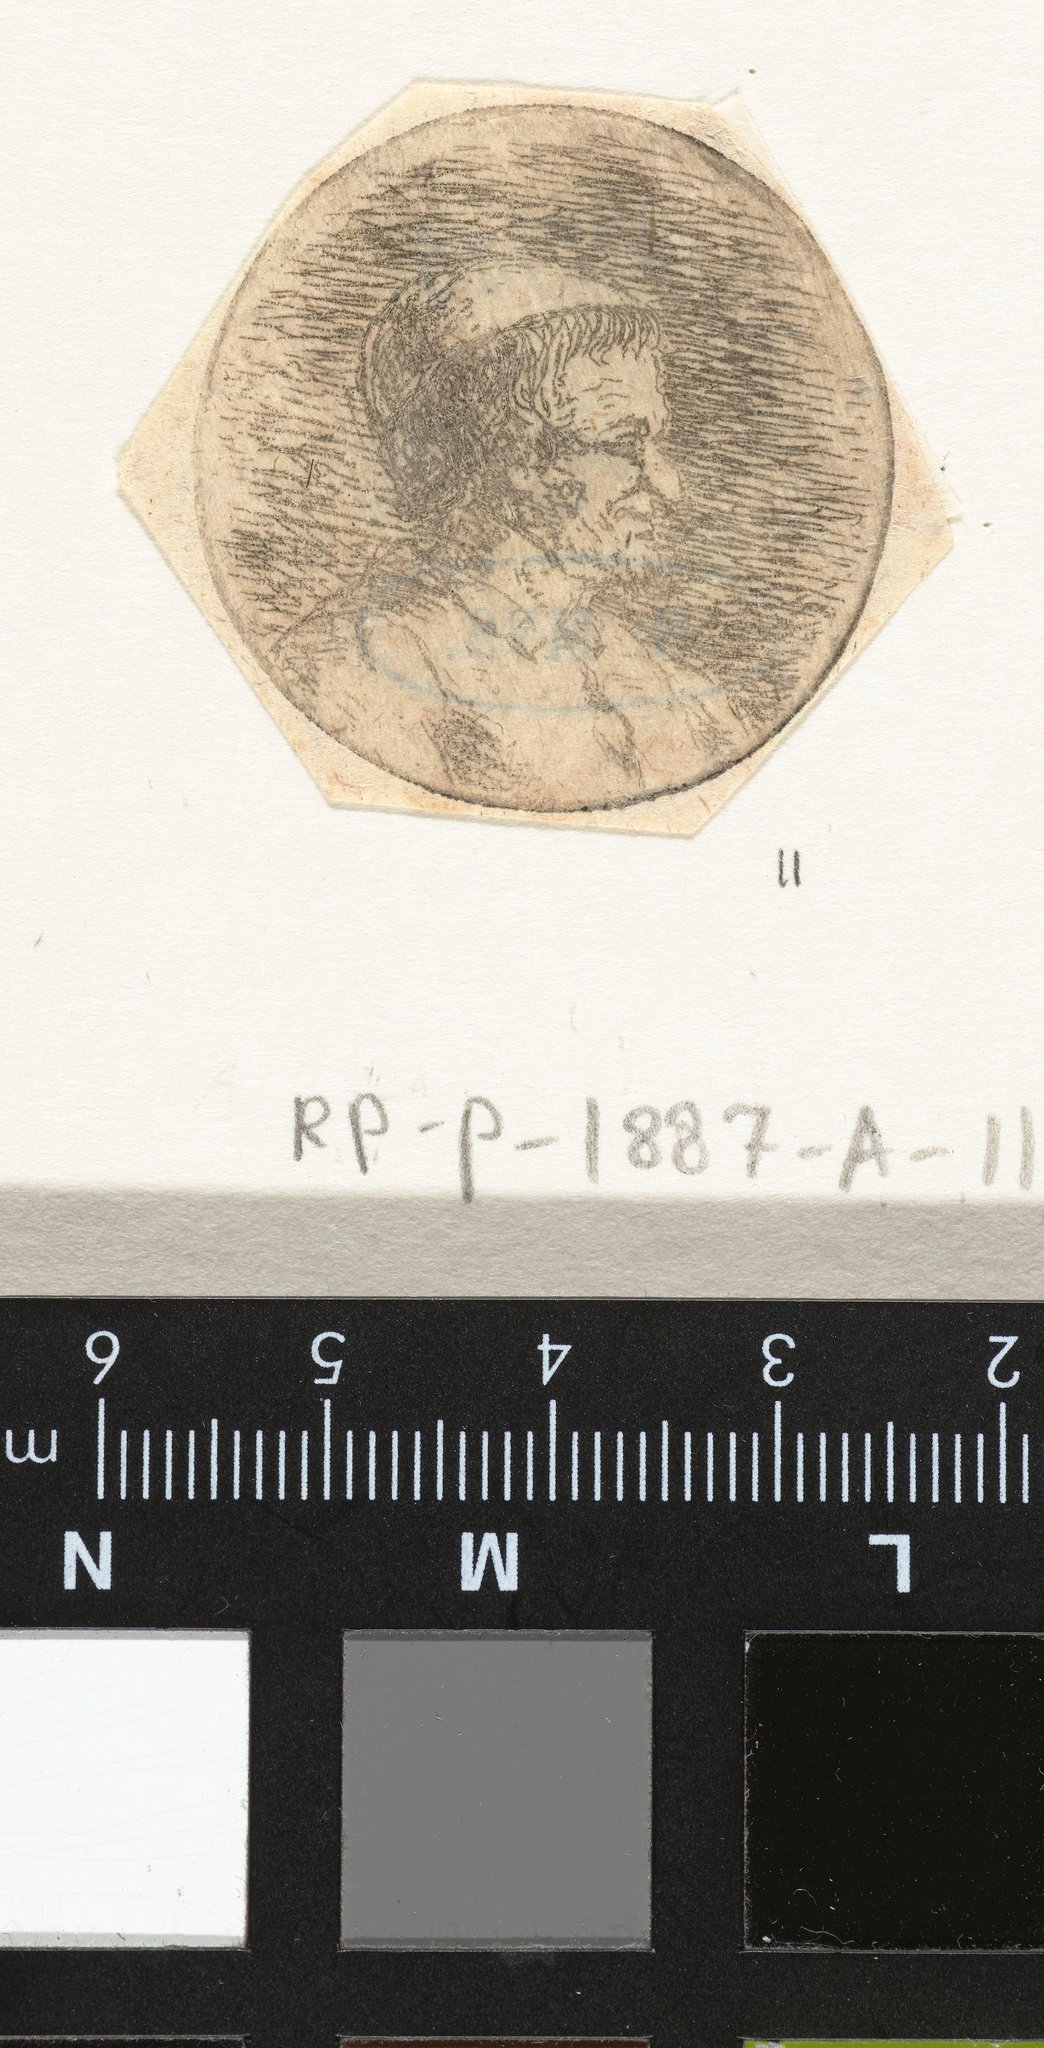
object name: print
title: Buste van een onbekende man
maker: christina chalon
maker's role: draughtsman, print maker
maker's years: 1748-1808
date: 1758-1808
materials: paper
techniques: etching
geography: leiden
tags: historical persons (portraits and scenes from the life) (+ profile portrait), morphology of human expression (+ adult male (human being))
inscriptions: collector's mark: Lugt 2228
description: In een ronde lijst, de buste van een onbekende volwassen man. Buste naar rechts.